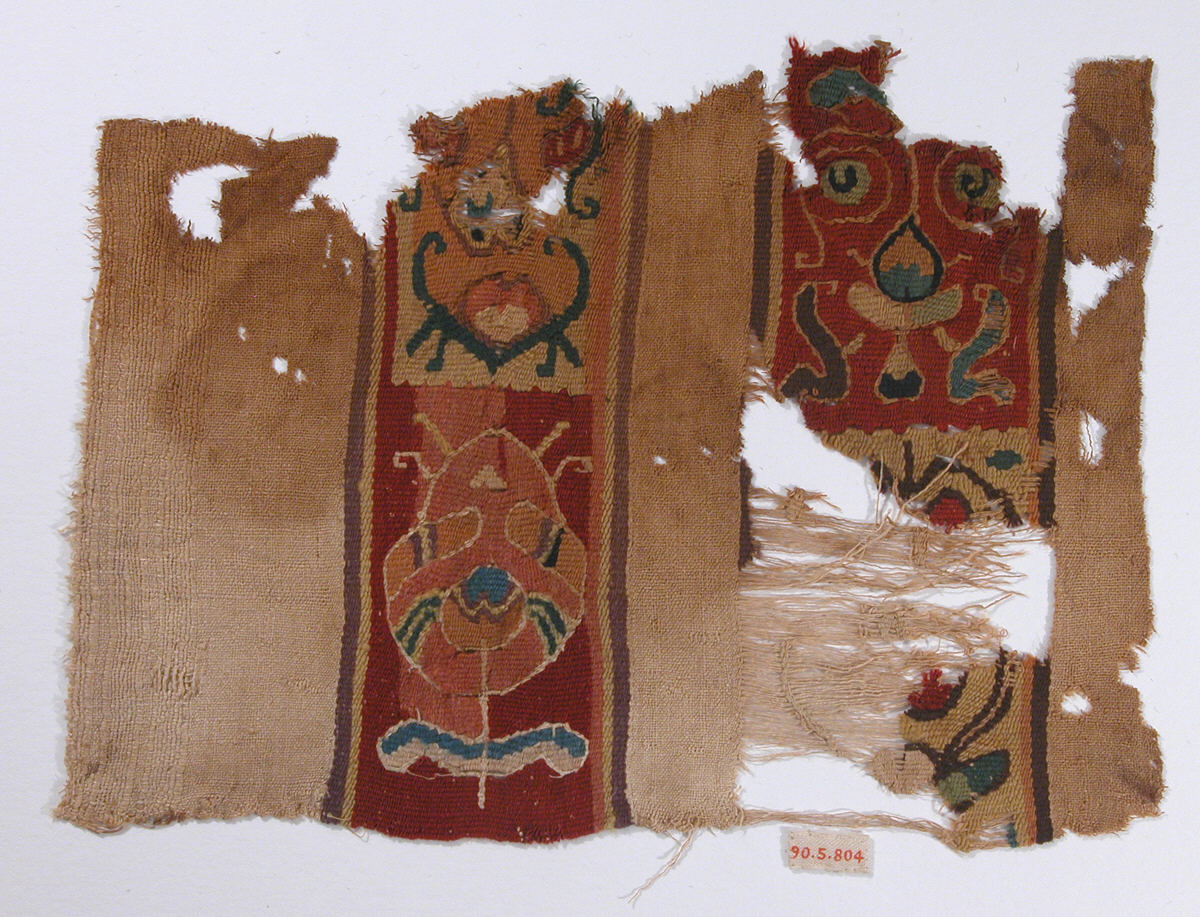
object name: textile fragment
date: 401-600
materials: linen, wool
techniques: weave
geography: egypt